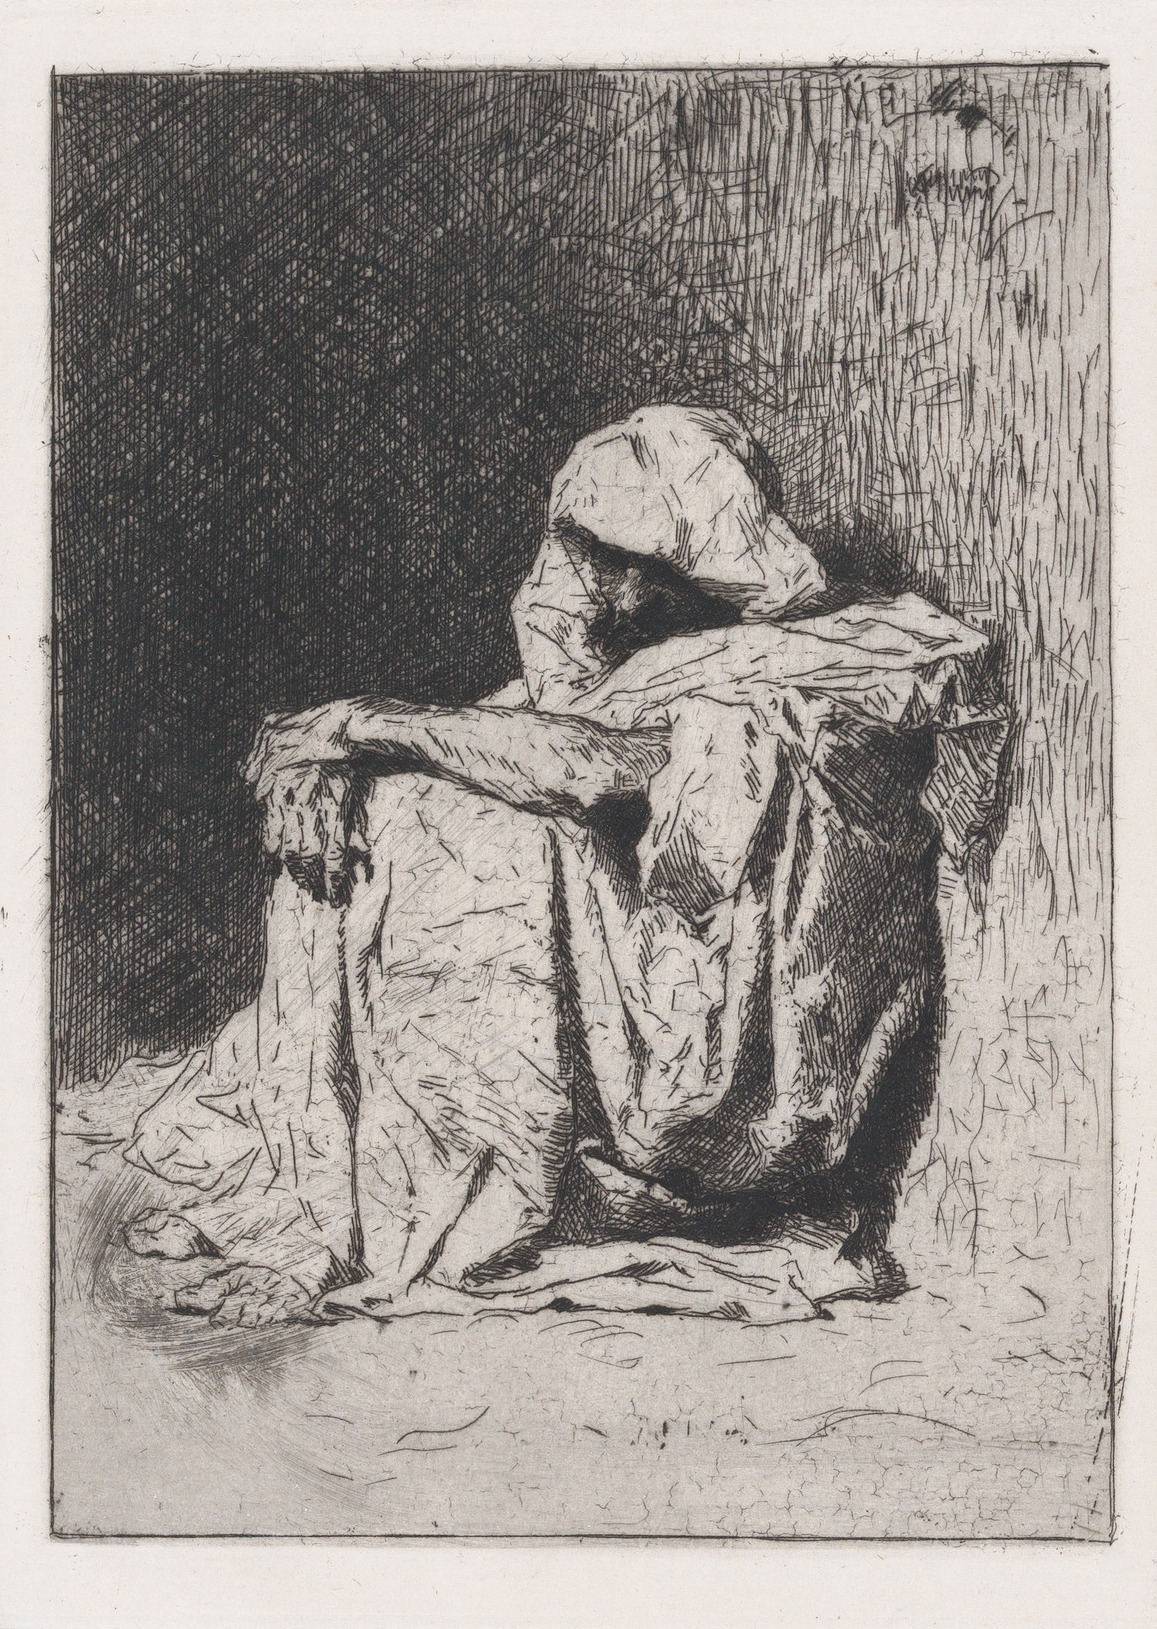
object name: print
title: An Arabic man seated on the ground, head partly covered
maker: mariano fortuny, 1838–1874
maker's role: artist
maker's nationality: spanish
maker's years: 1838-1874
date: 1860-1862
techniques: etching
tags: men